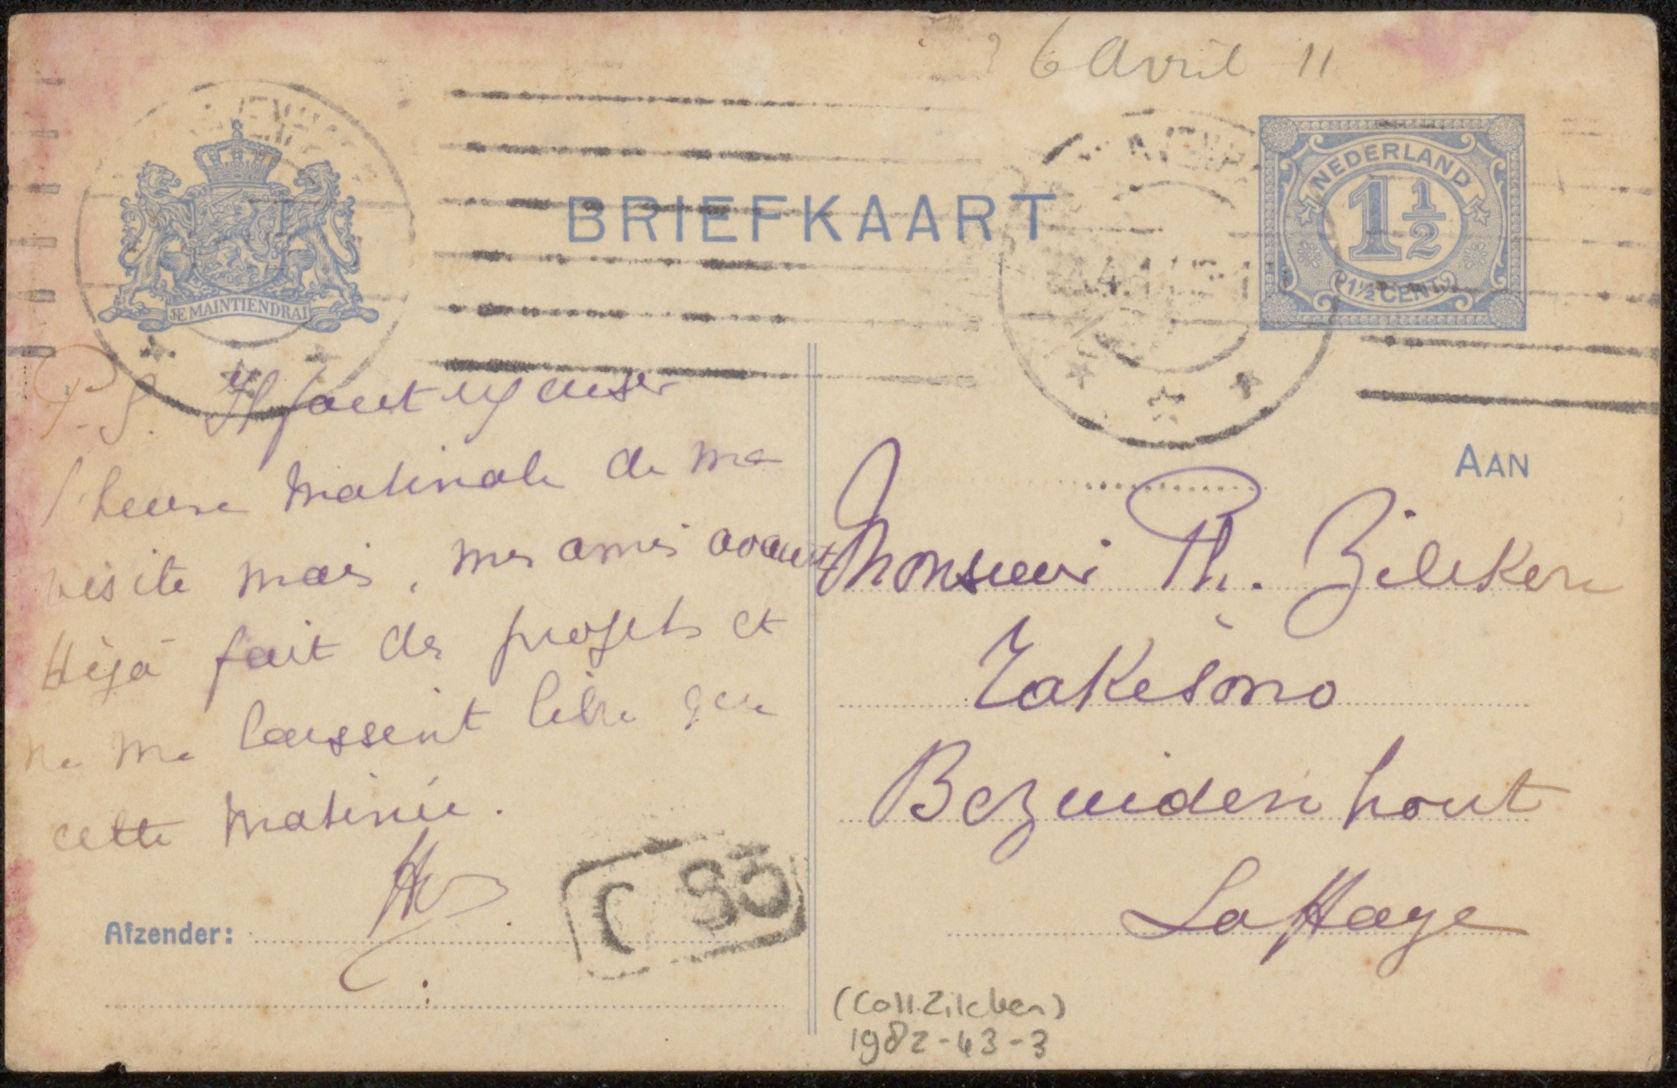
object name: postcard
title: Briefkaart aan Philip Zilcken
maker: hélène van goethem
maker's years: 1866-1919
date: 1911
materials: cardboard, ink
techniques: pen, writing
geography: the hague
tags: painter, philip zilcken, the hague